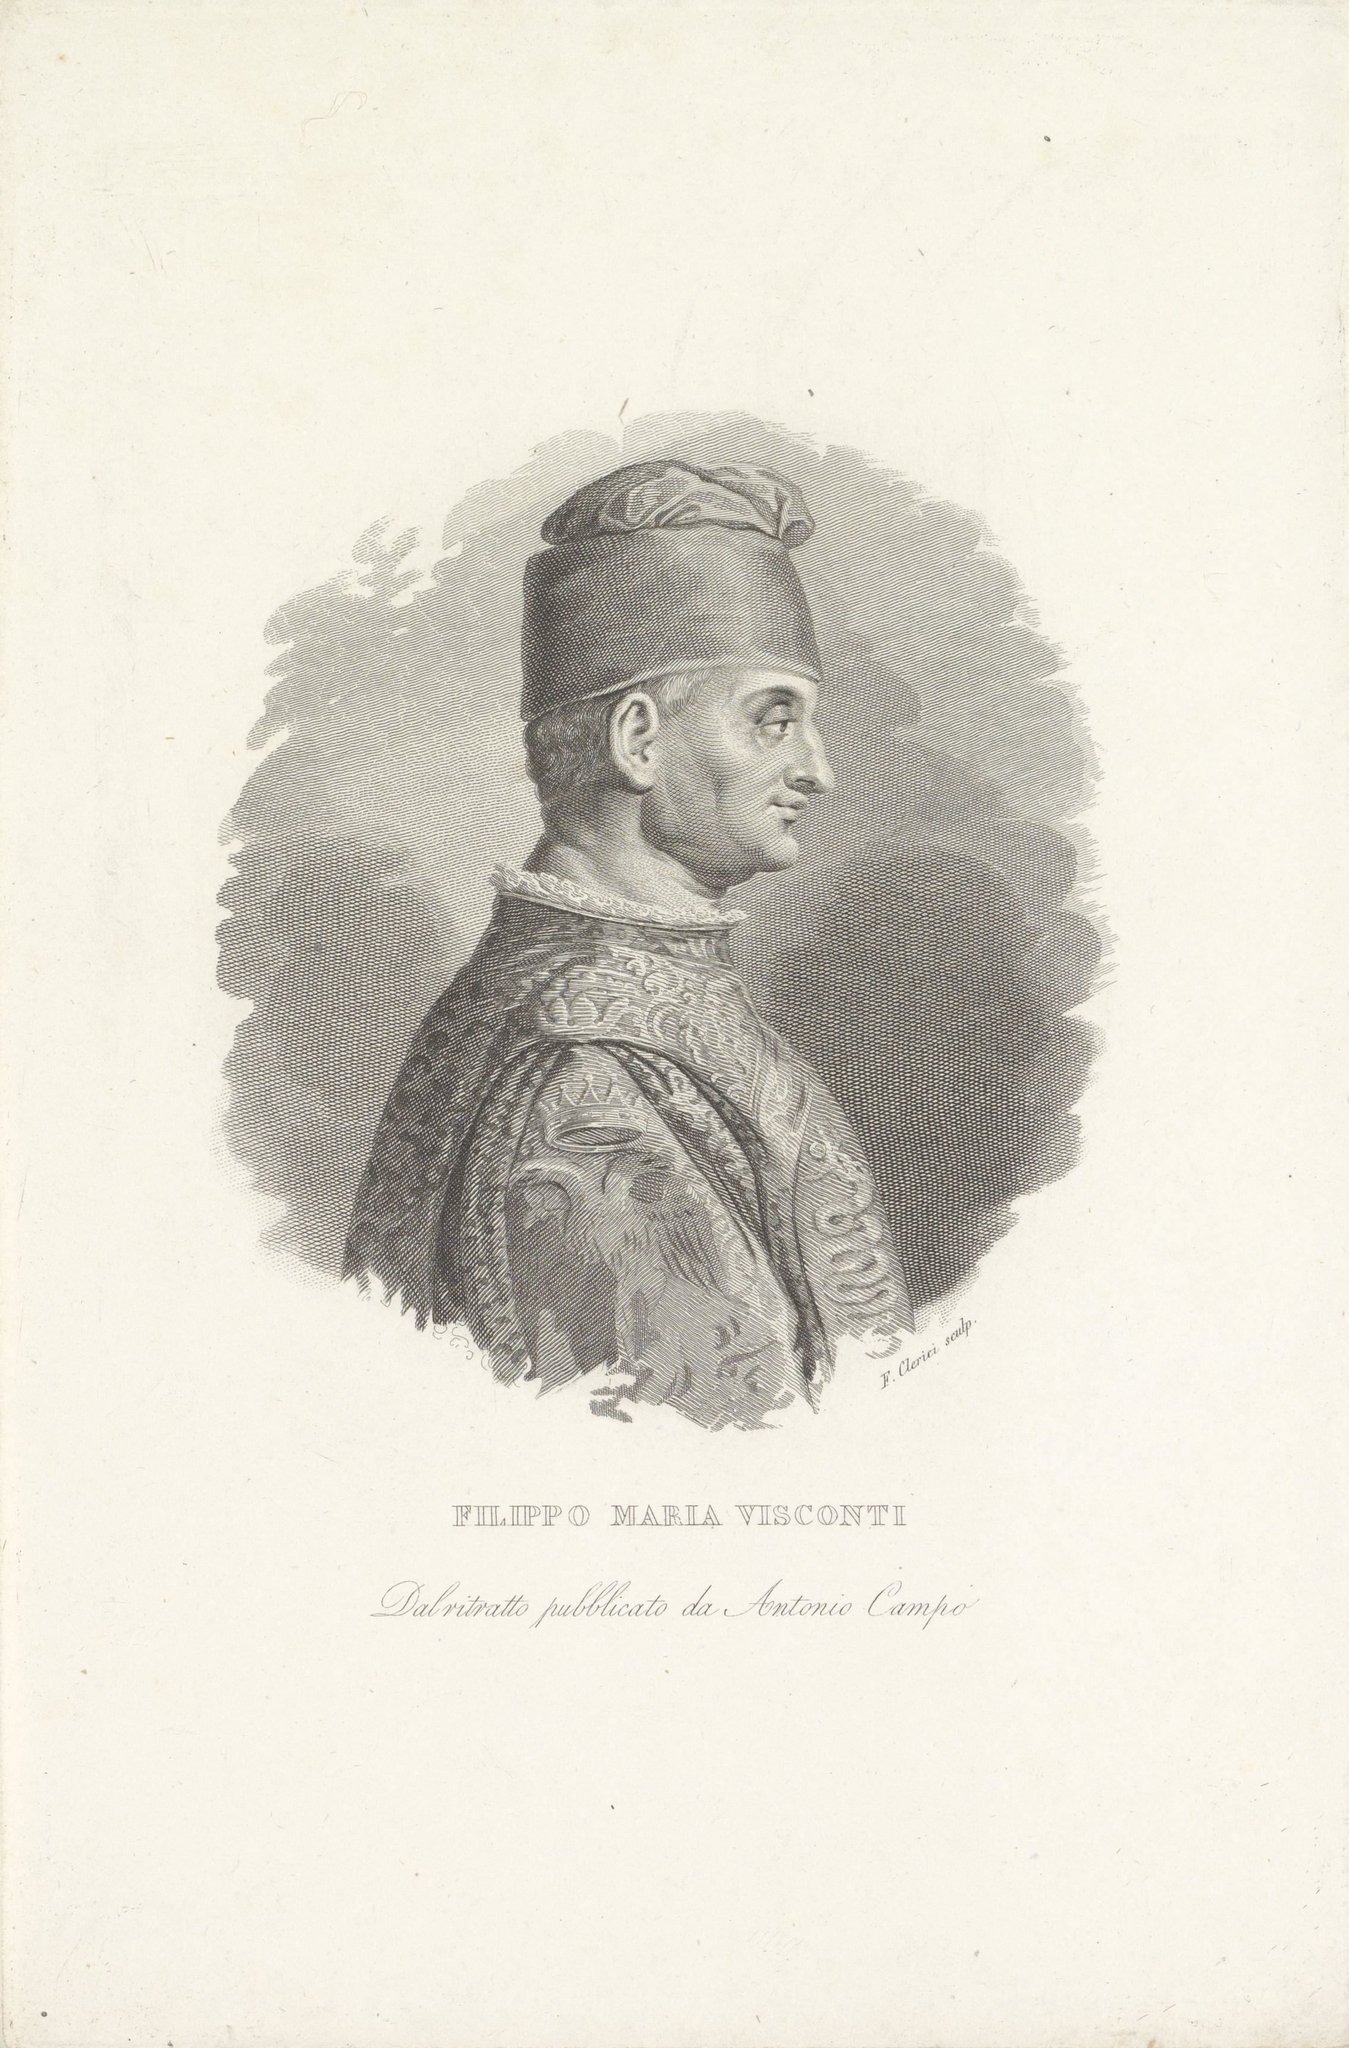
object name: print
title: Portret van Filippo Maria Visconti, hertog van Milaan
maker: francesco clerici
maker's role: print maker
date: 1855-1865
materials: paper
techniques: engraving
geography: italy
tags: historical persons, ruler, sovereign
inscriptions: collector's mark: Lugt 2228